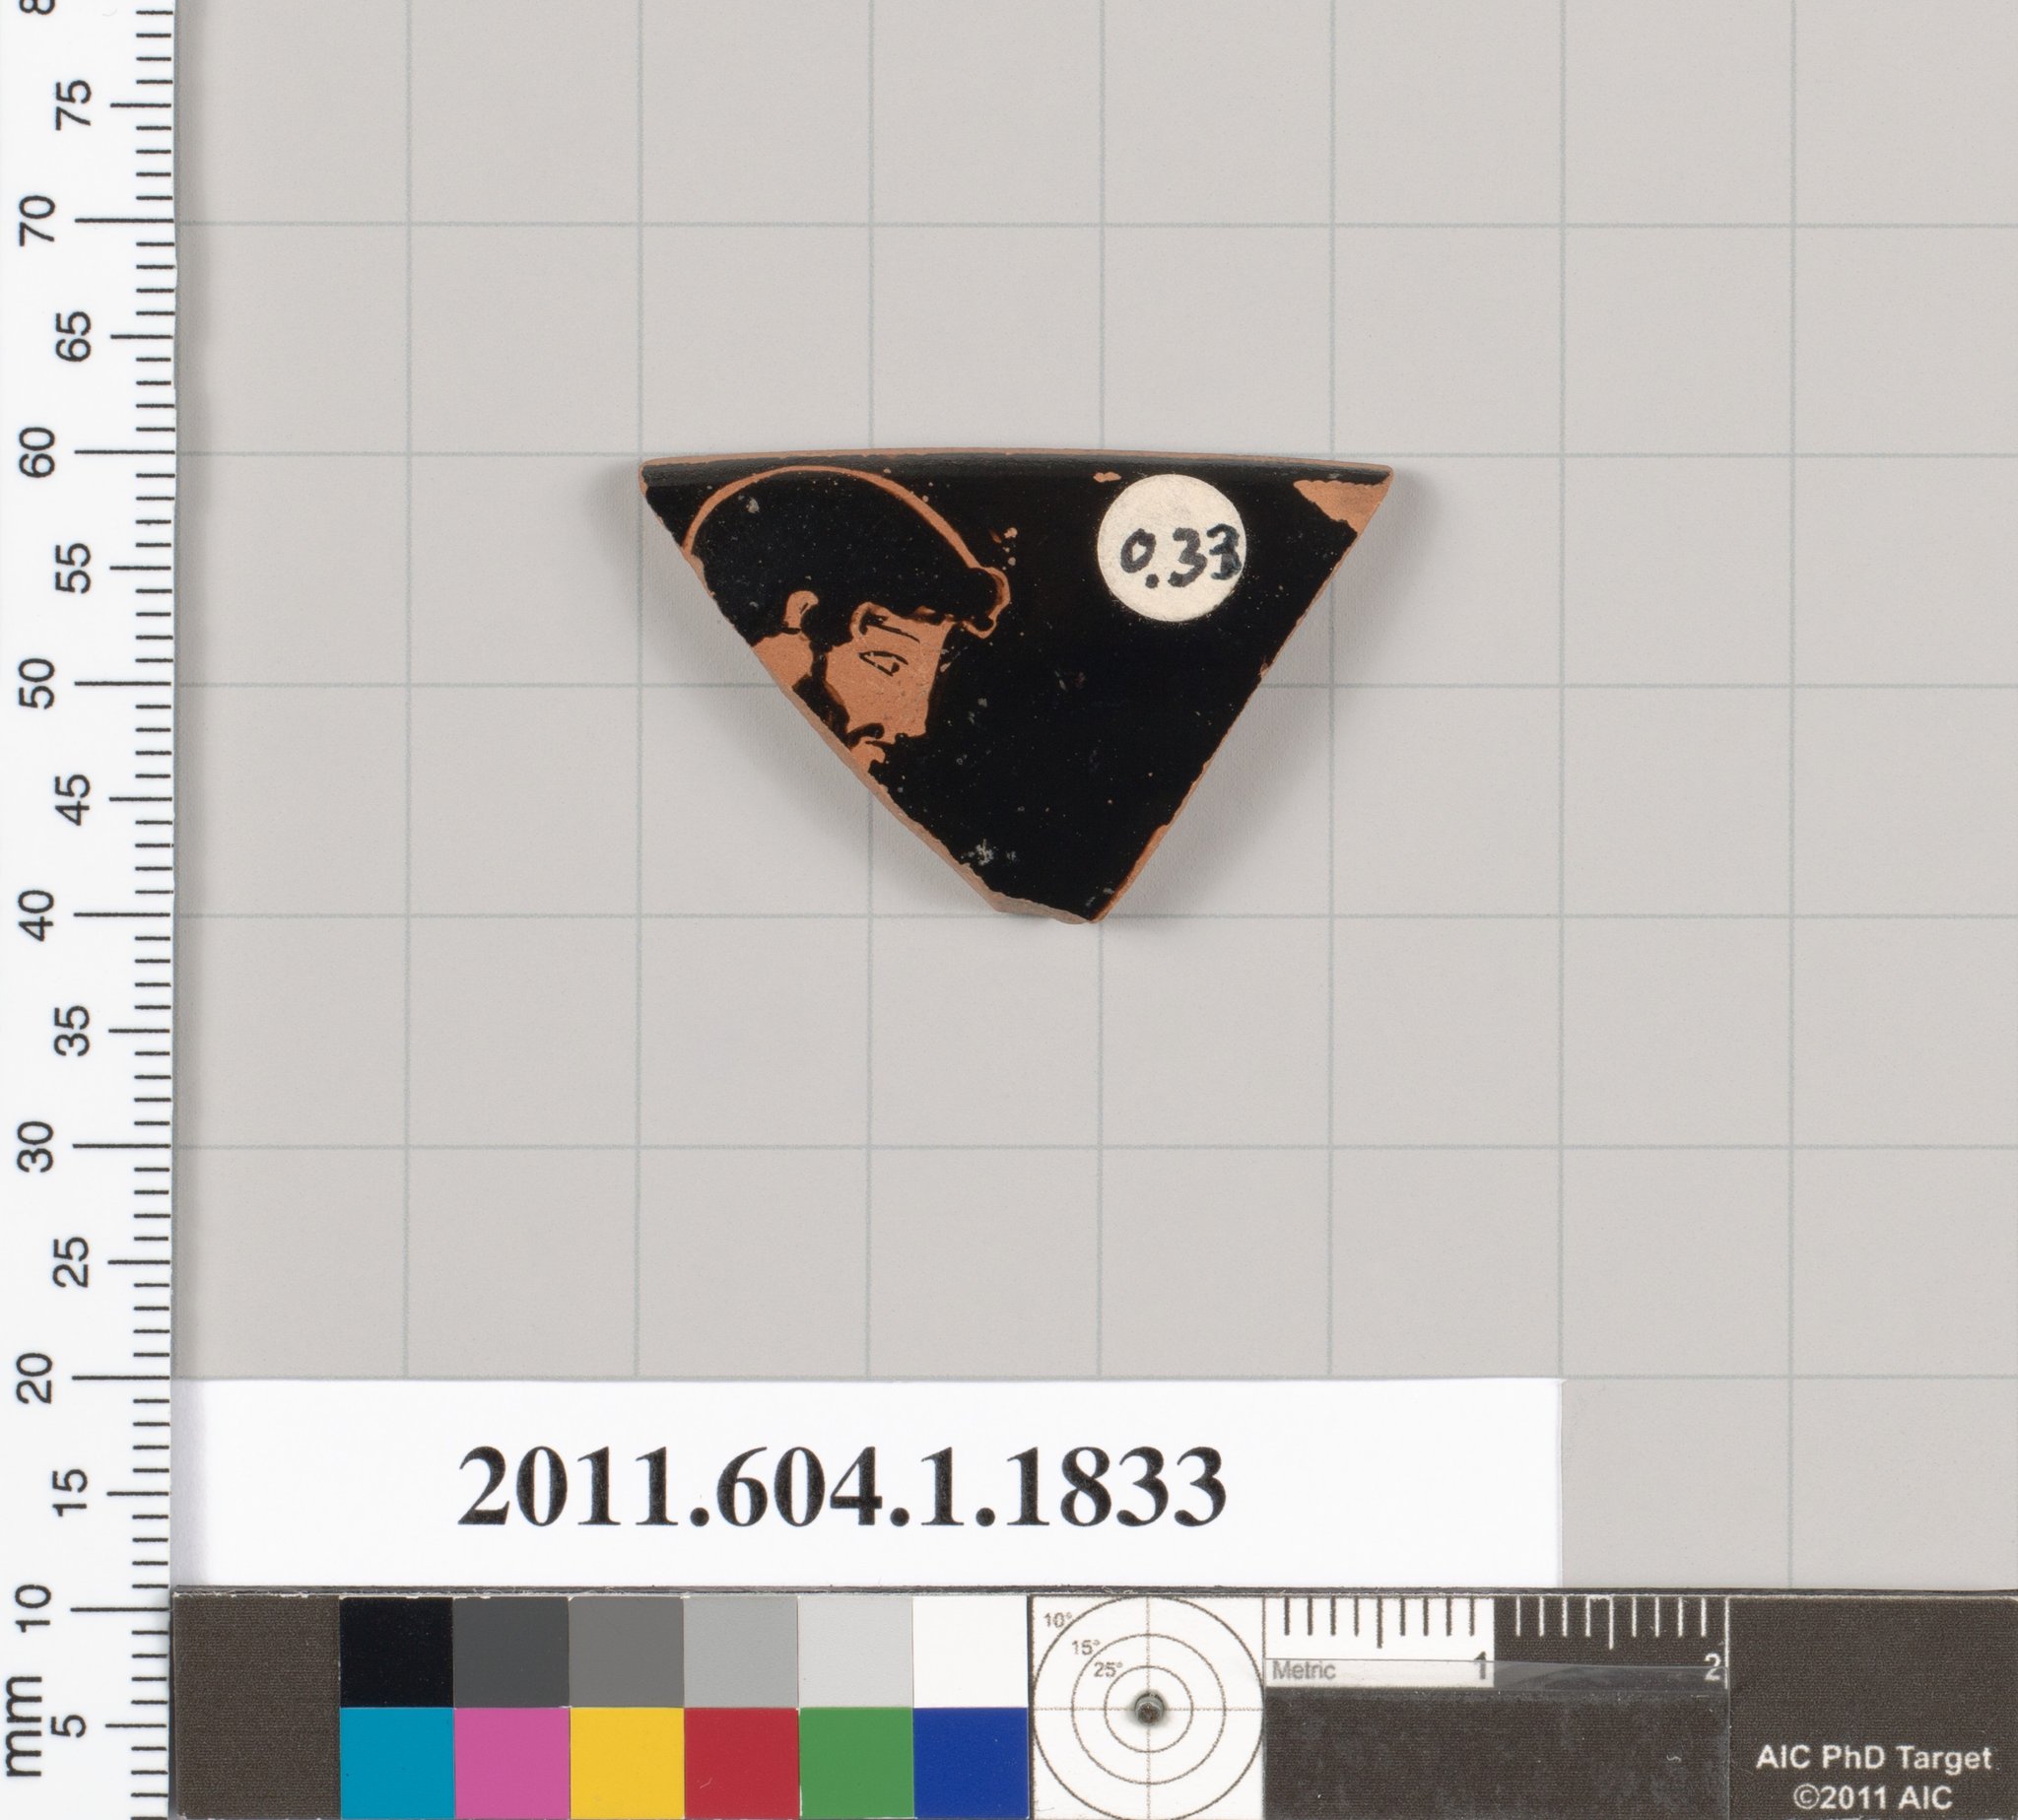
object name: kylix fragment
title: Terracotta rim fragment of a kylix (drinking cup)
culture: greek, attic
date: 480-470 BCE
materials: terracotta